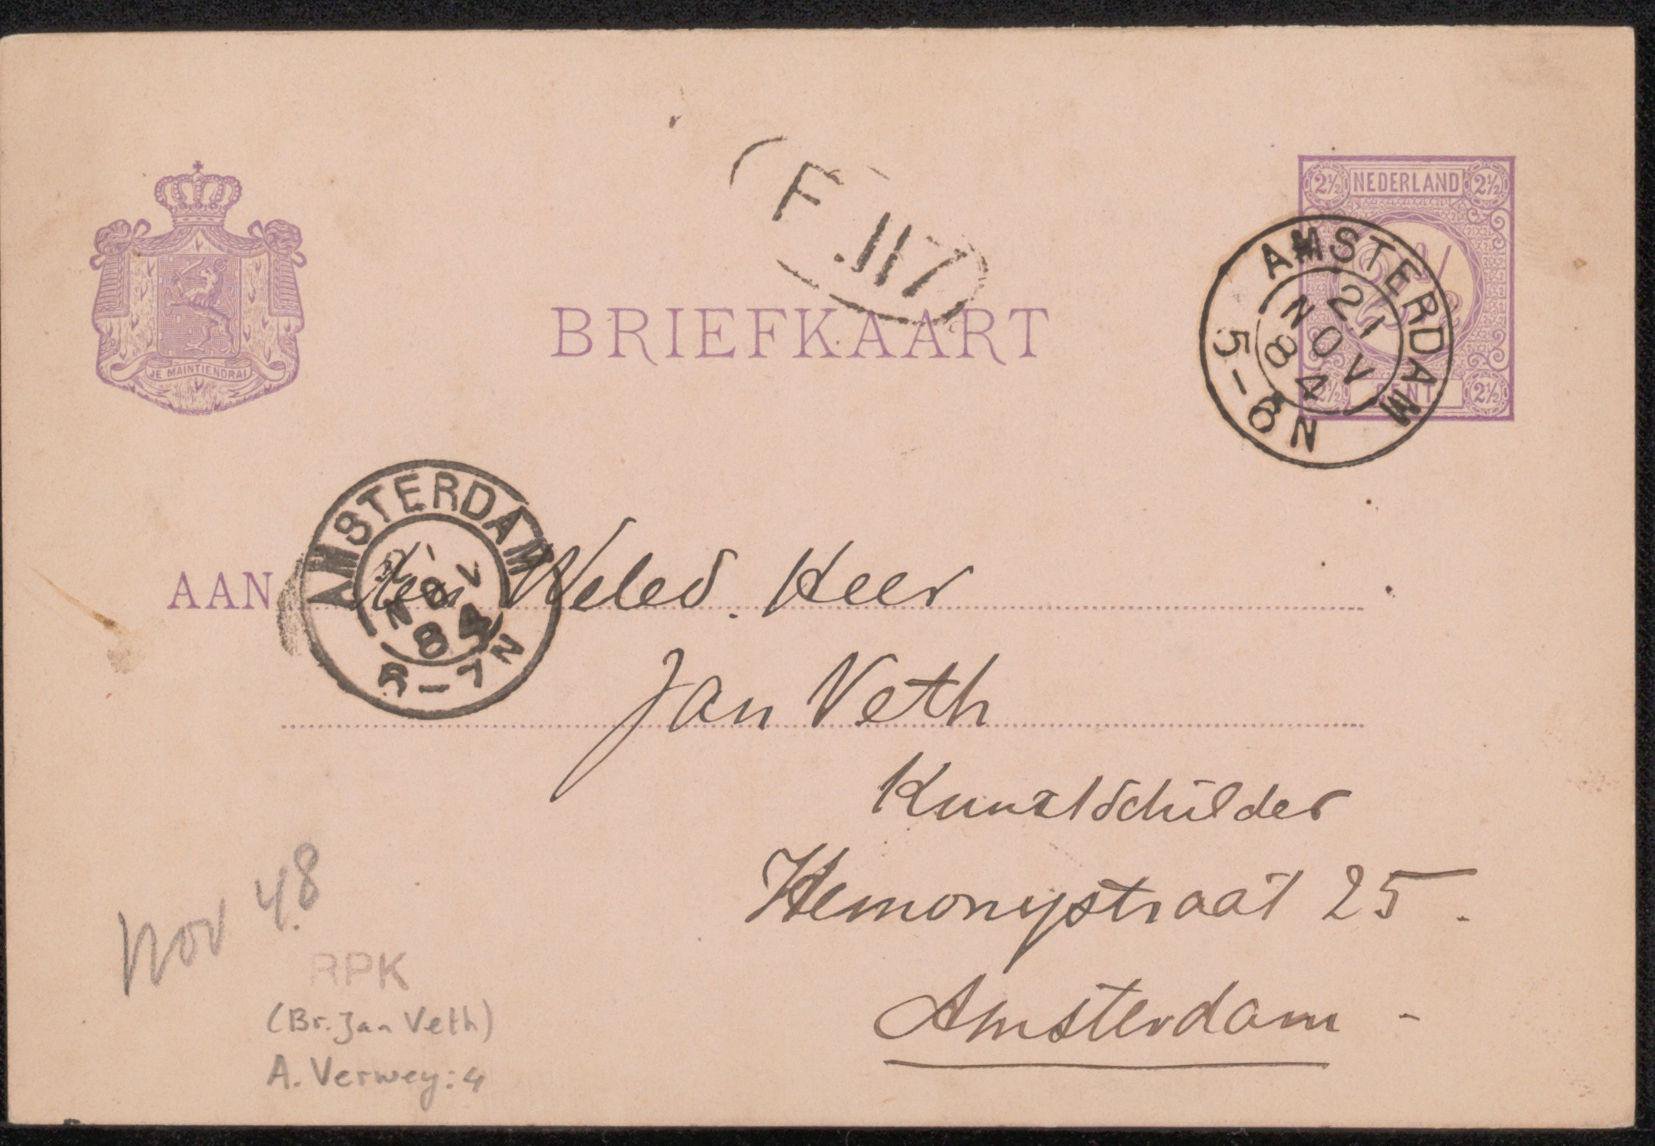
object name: postcard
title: Briefkaart aan Jan Veth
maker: albert verwey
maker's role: criticus, dichter, essayist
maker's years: 1865-1937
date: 1884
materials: cardboard, ink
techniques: pen, writing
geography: amsterdam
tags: dordrecht, painter, draughtsman, jan veth, rome, priest, herman johannes aloysius maria schaepman, lodewijk van deyssel, amsterdam, the hague, willem kloos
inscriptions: collector's mark: ‘RPK’